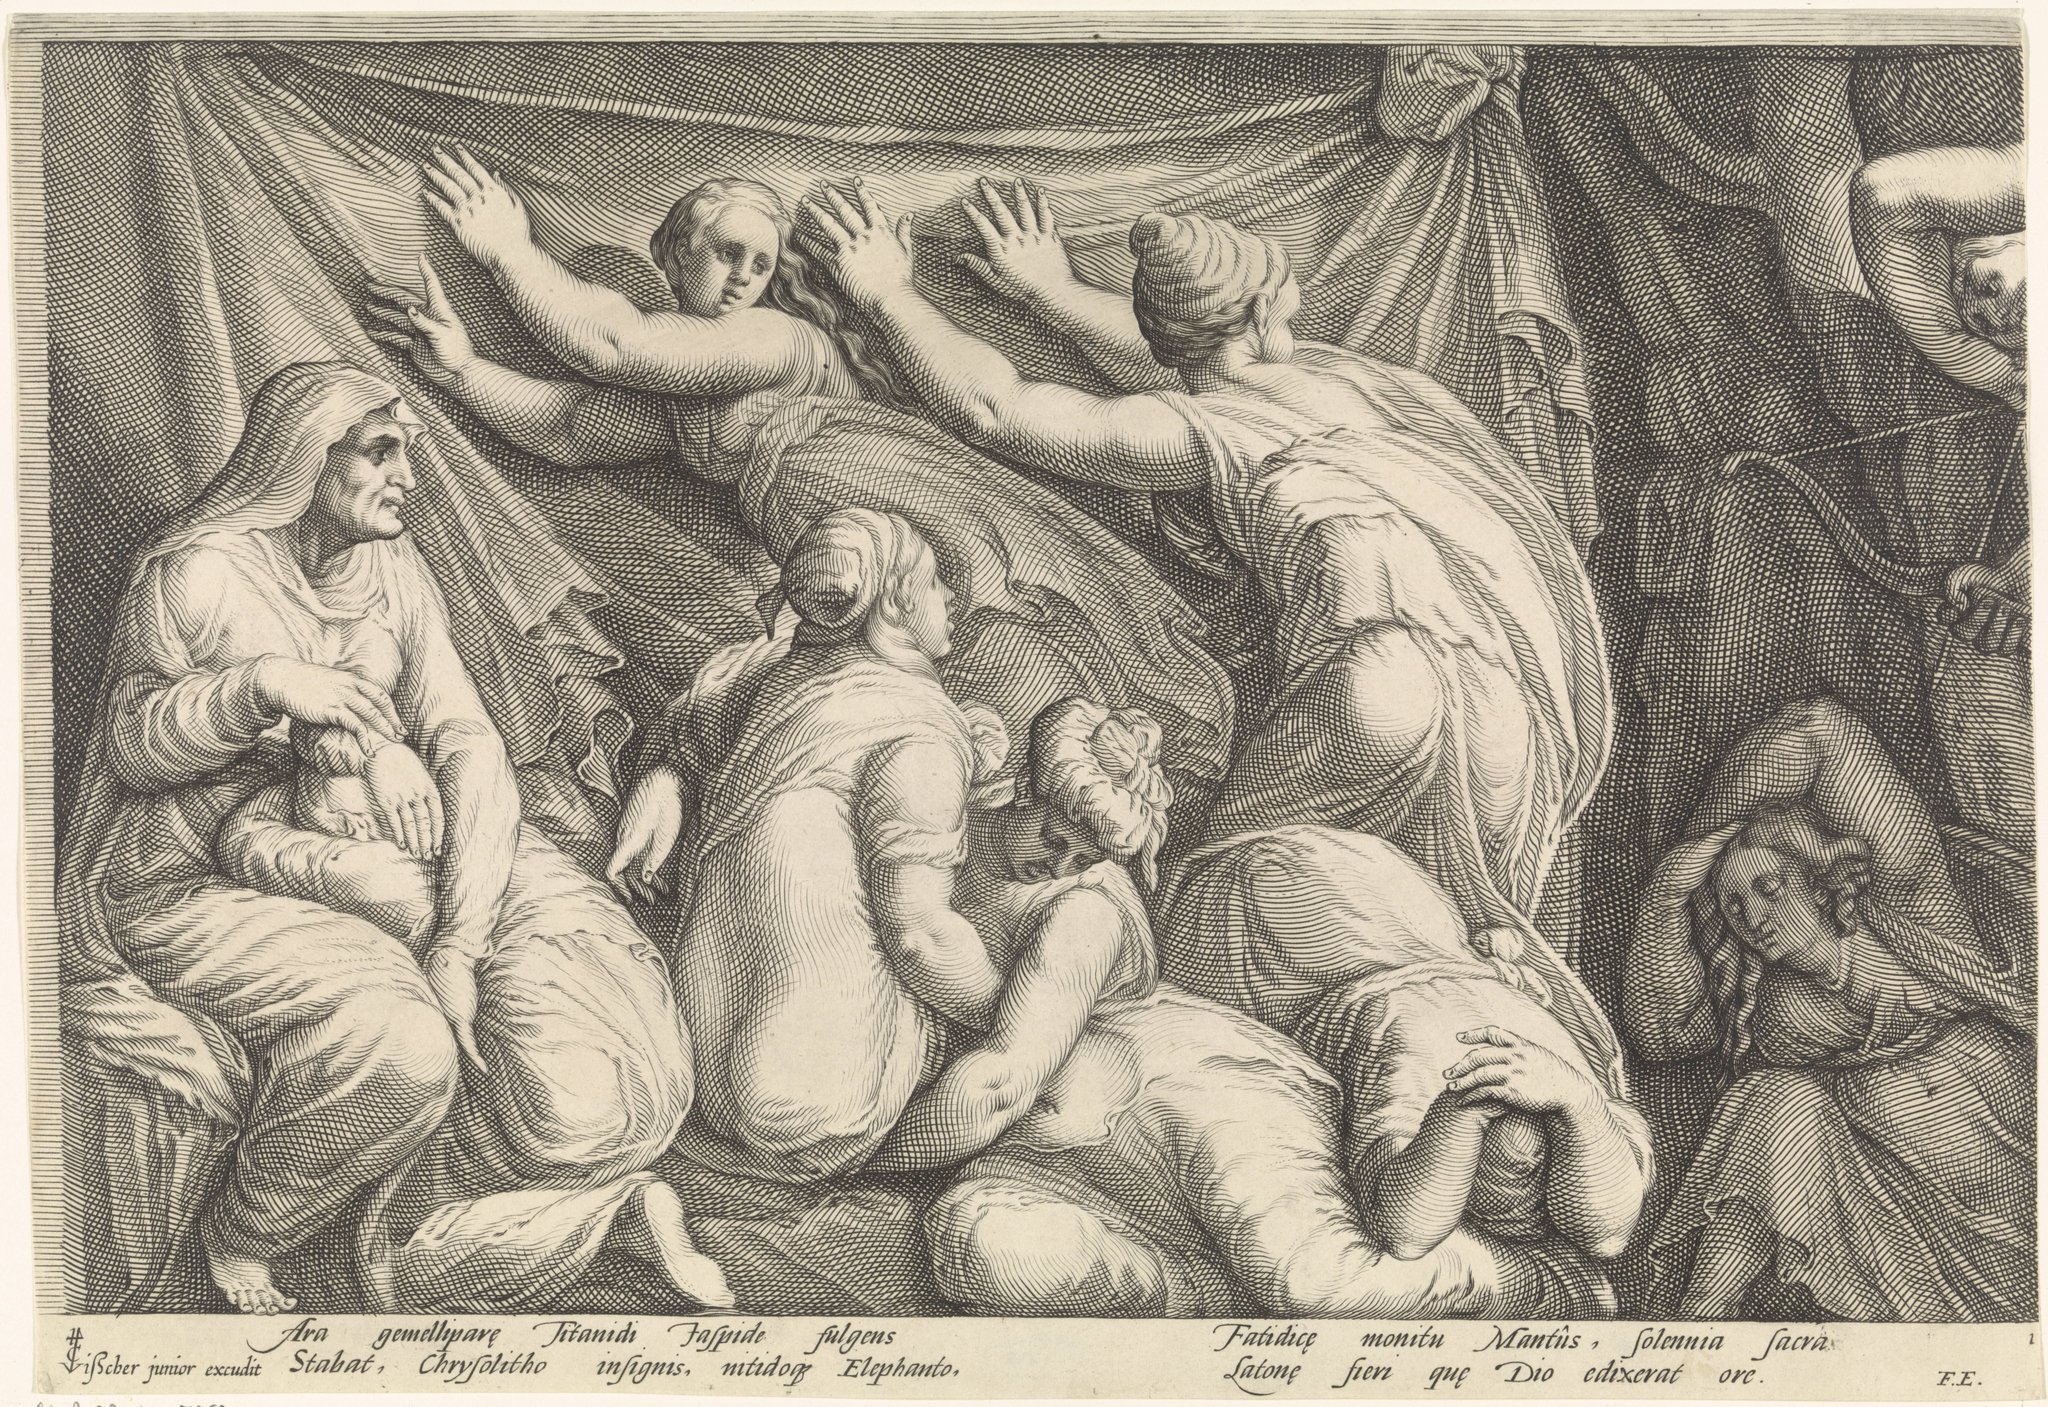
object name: print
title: Fries met de bestraffing van Niobe (plaat 1)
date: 1594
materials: paper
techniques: engraving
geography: rome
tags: apollo and diana kill niobe's children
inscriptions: collector's mark: Lugt 2228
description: De veertien kinderen van Niobe worden door Apollo en Diana gedood met pijlen. Links in de hoek zit Niobe die tracht haar kinderen te beschermen. De prent heeft een Latijnse onderschrift. Uiterst linkerplaat van een prent met een fries uit acht platen